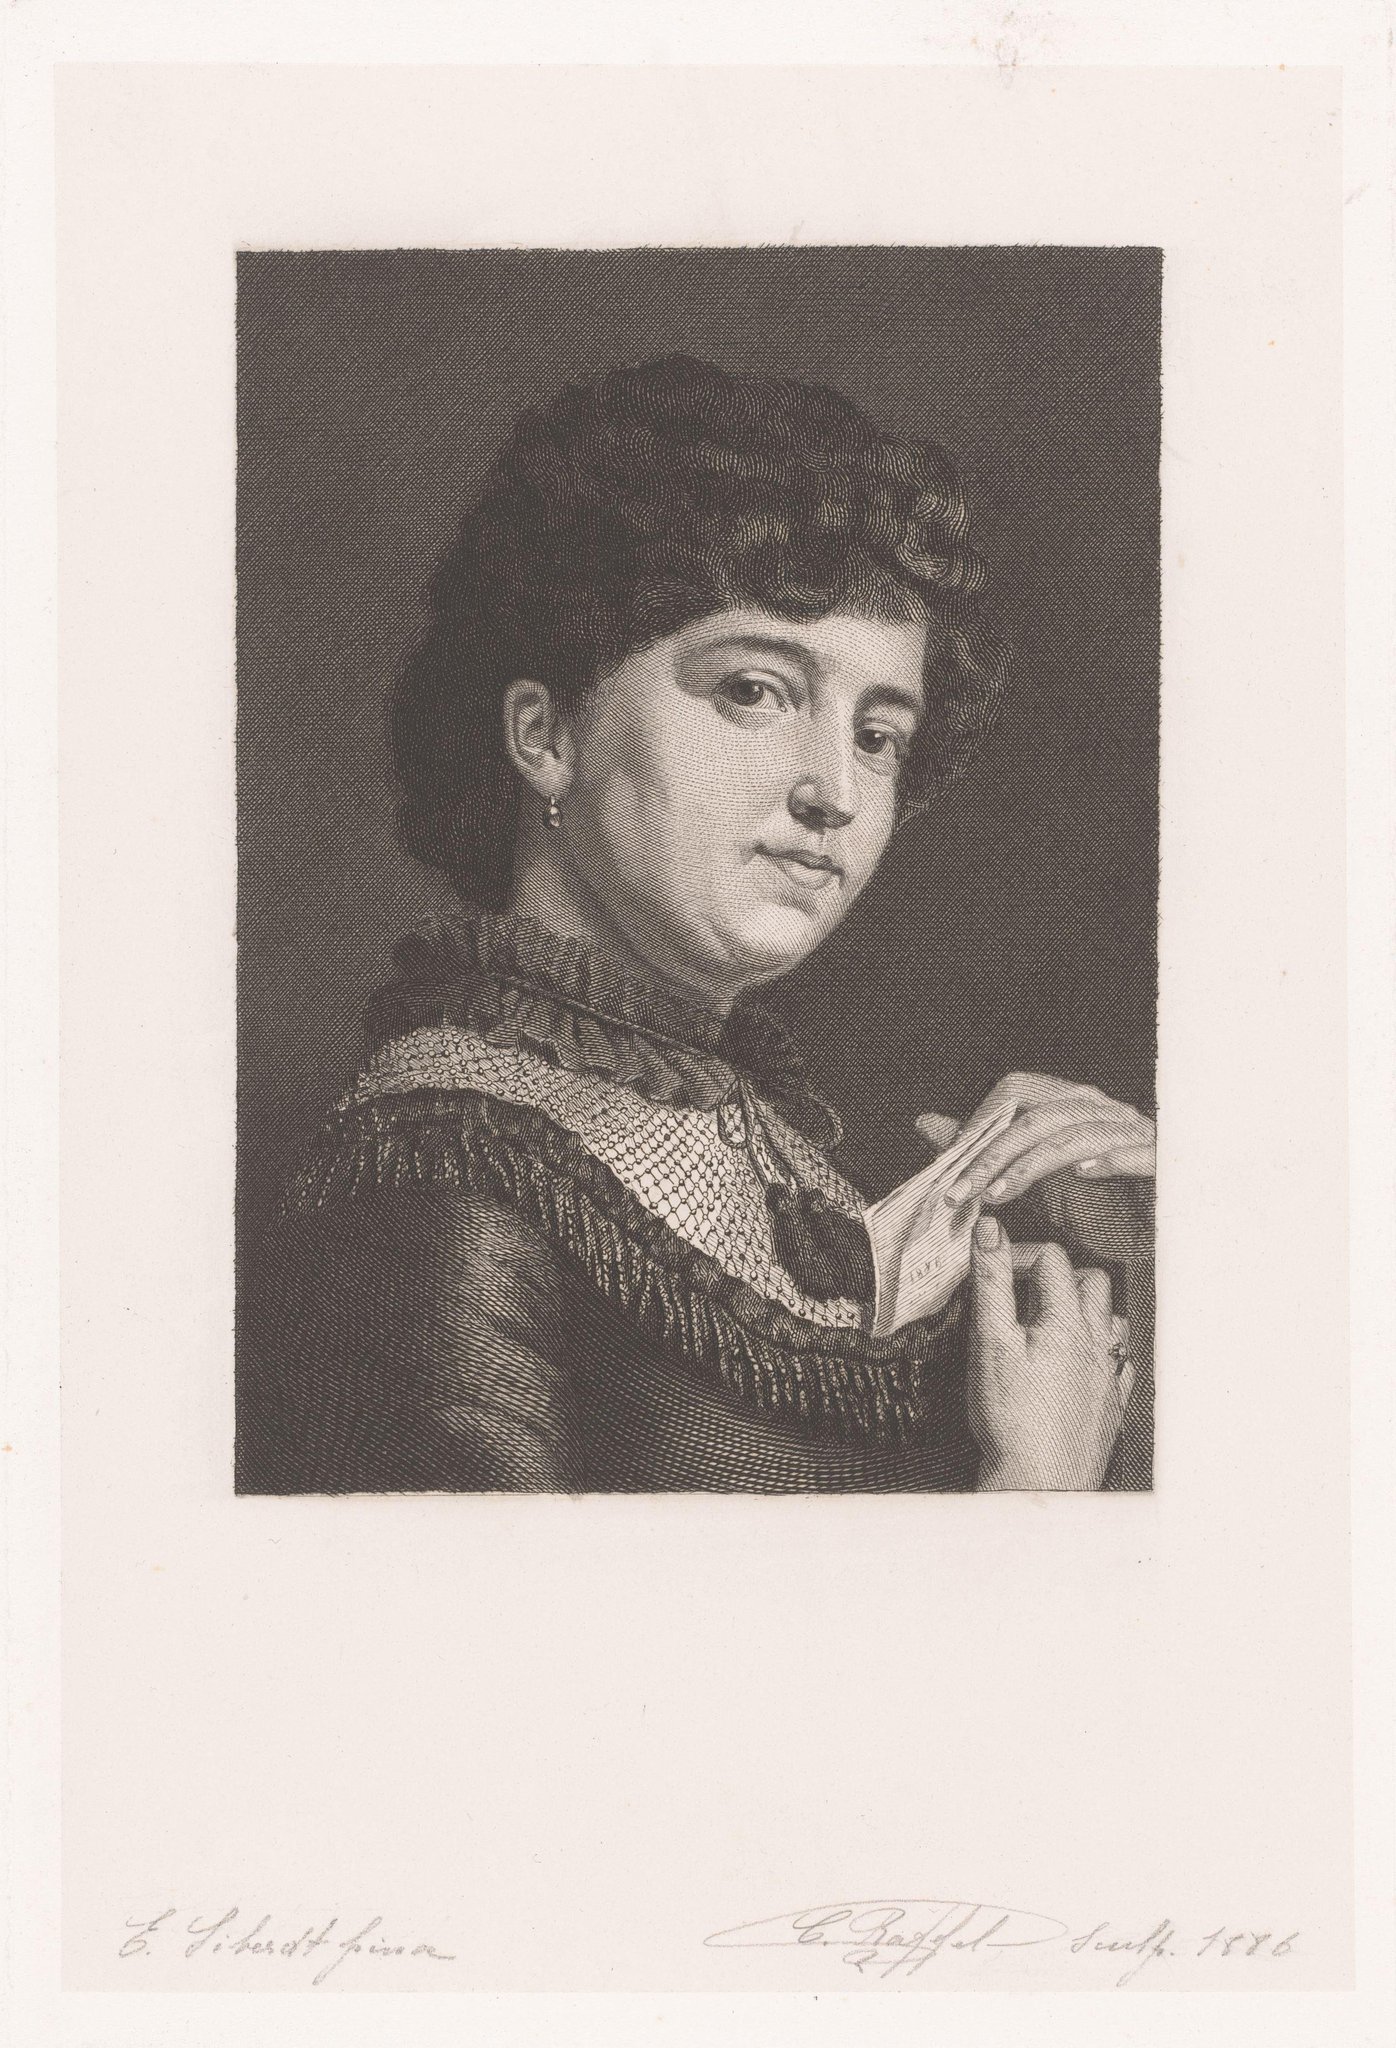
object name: print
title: Portret van een onbekende vrouw met brief in haar handen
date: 1886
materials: paper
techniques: engraving, etching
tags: adult woman, historical persons, letter, envelope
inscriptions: collector's mark: Lugt 2228